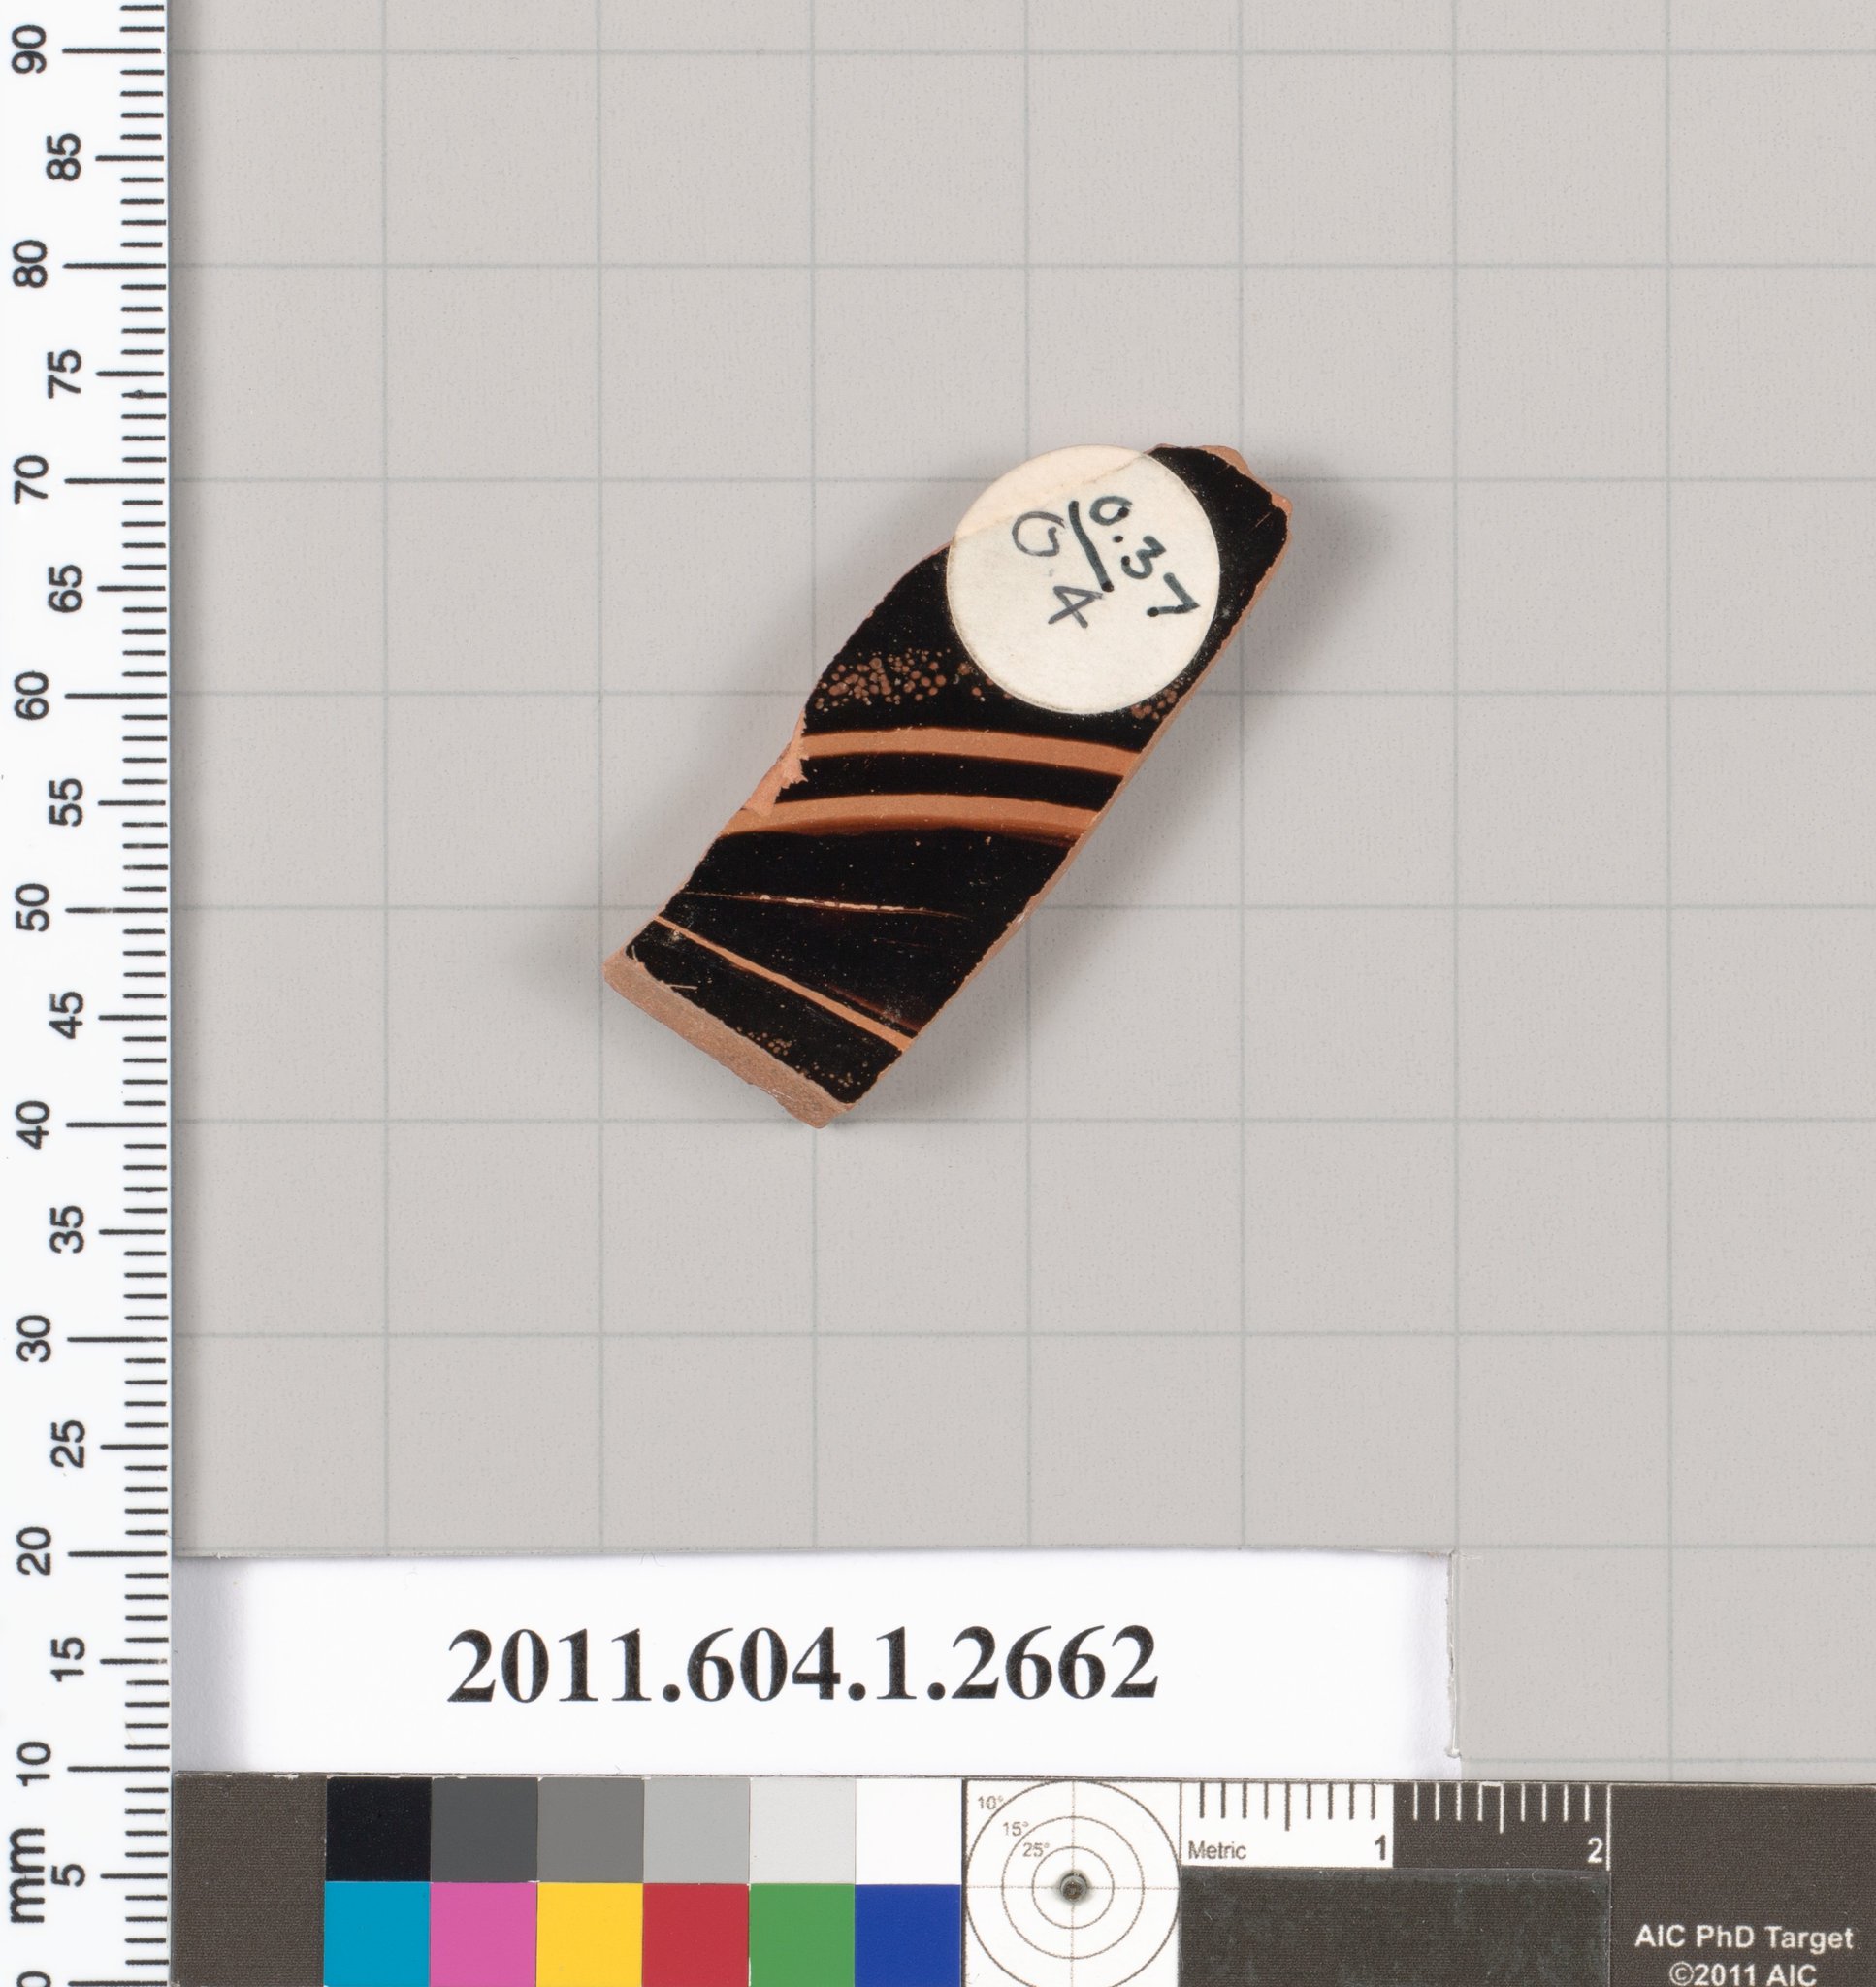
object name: kylix fragment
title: Terracotta fragment of a kylix (drinking cup)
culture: greek, attic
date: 500-451 BCE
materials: terracotta